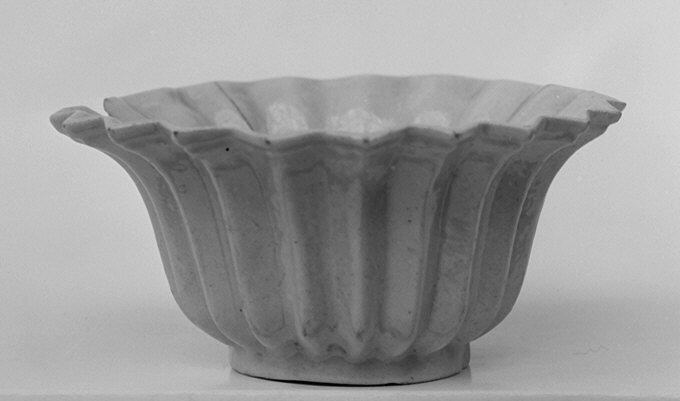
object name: jelly mold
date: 1750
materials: stoneware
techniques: salt glaze